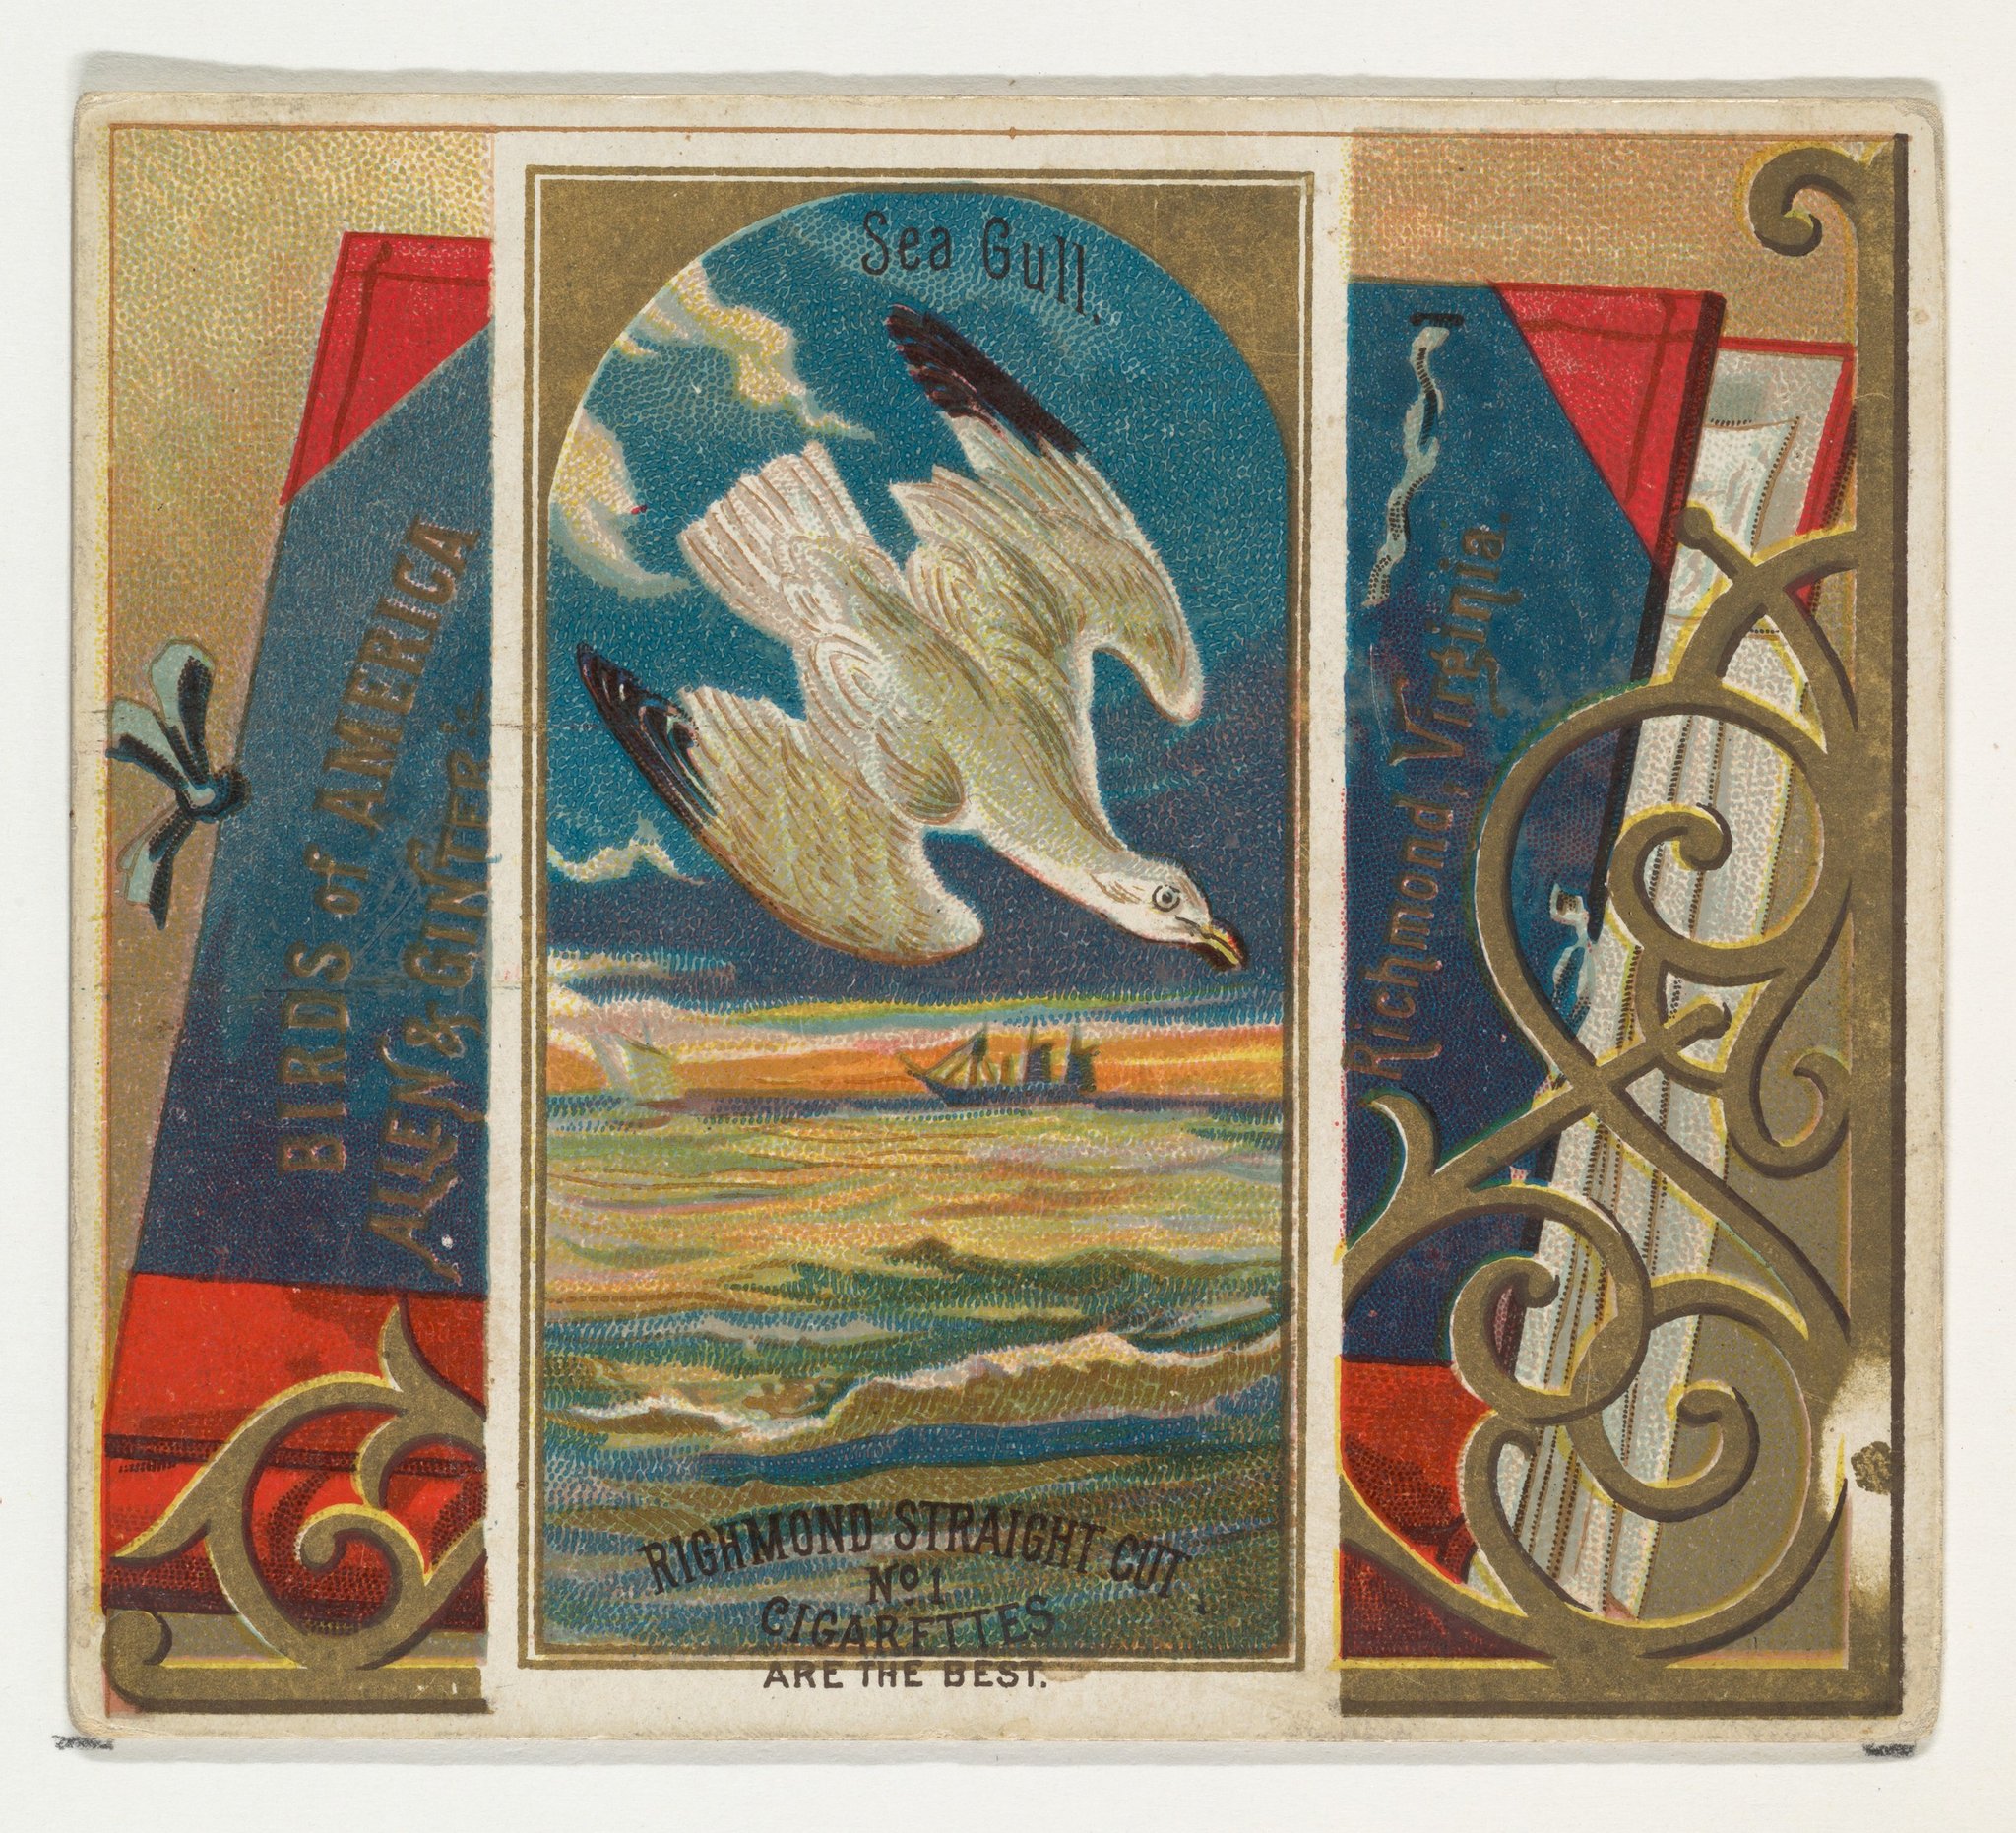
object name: print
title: Seagull, from the Birds of America series (N37) for Allen & Ginter Cigarettes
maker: allen & ginter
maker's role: publisher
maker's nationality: american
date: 1888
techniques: color lithograph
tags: birds